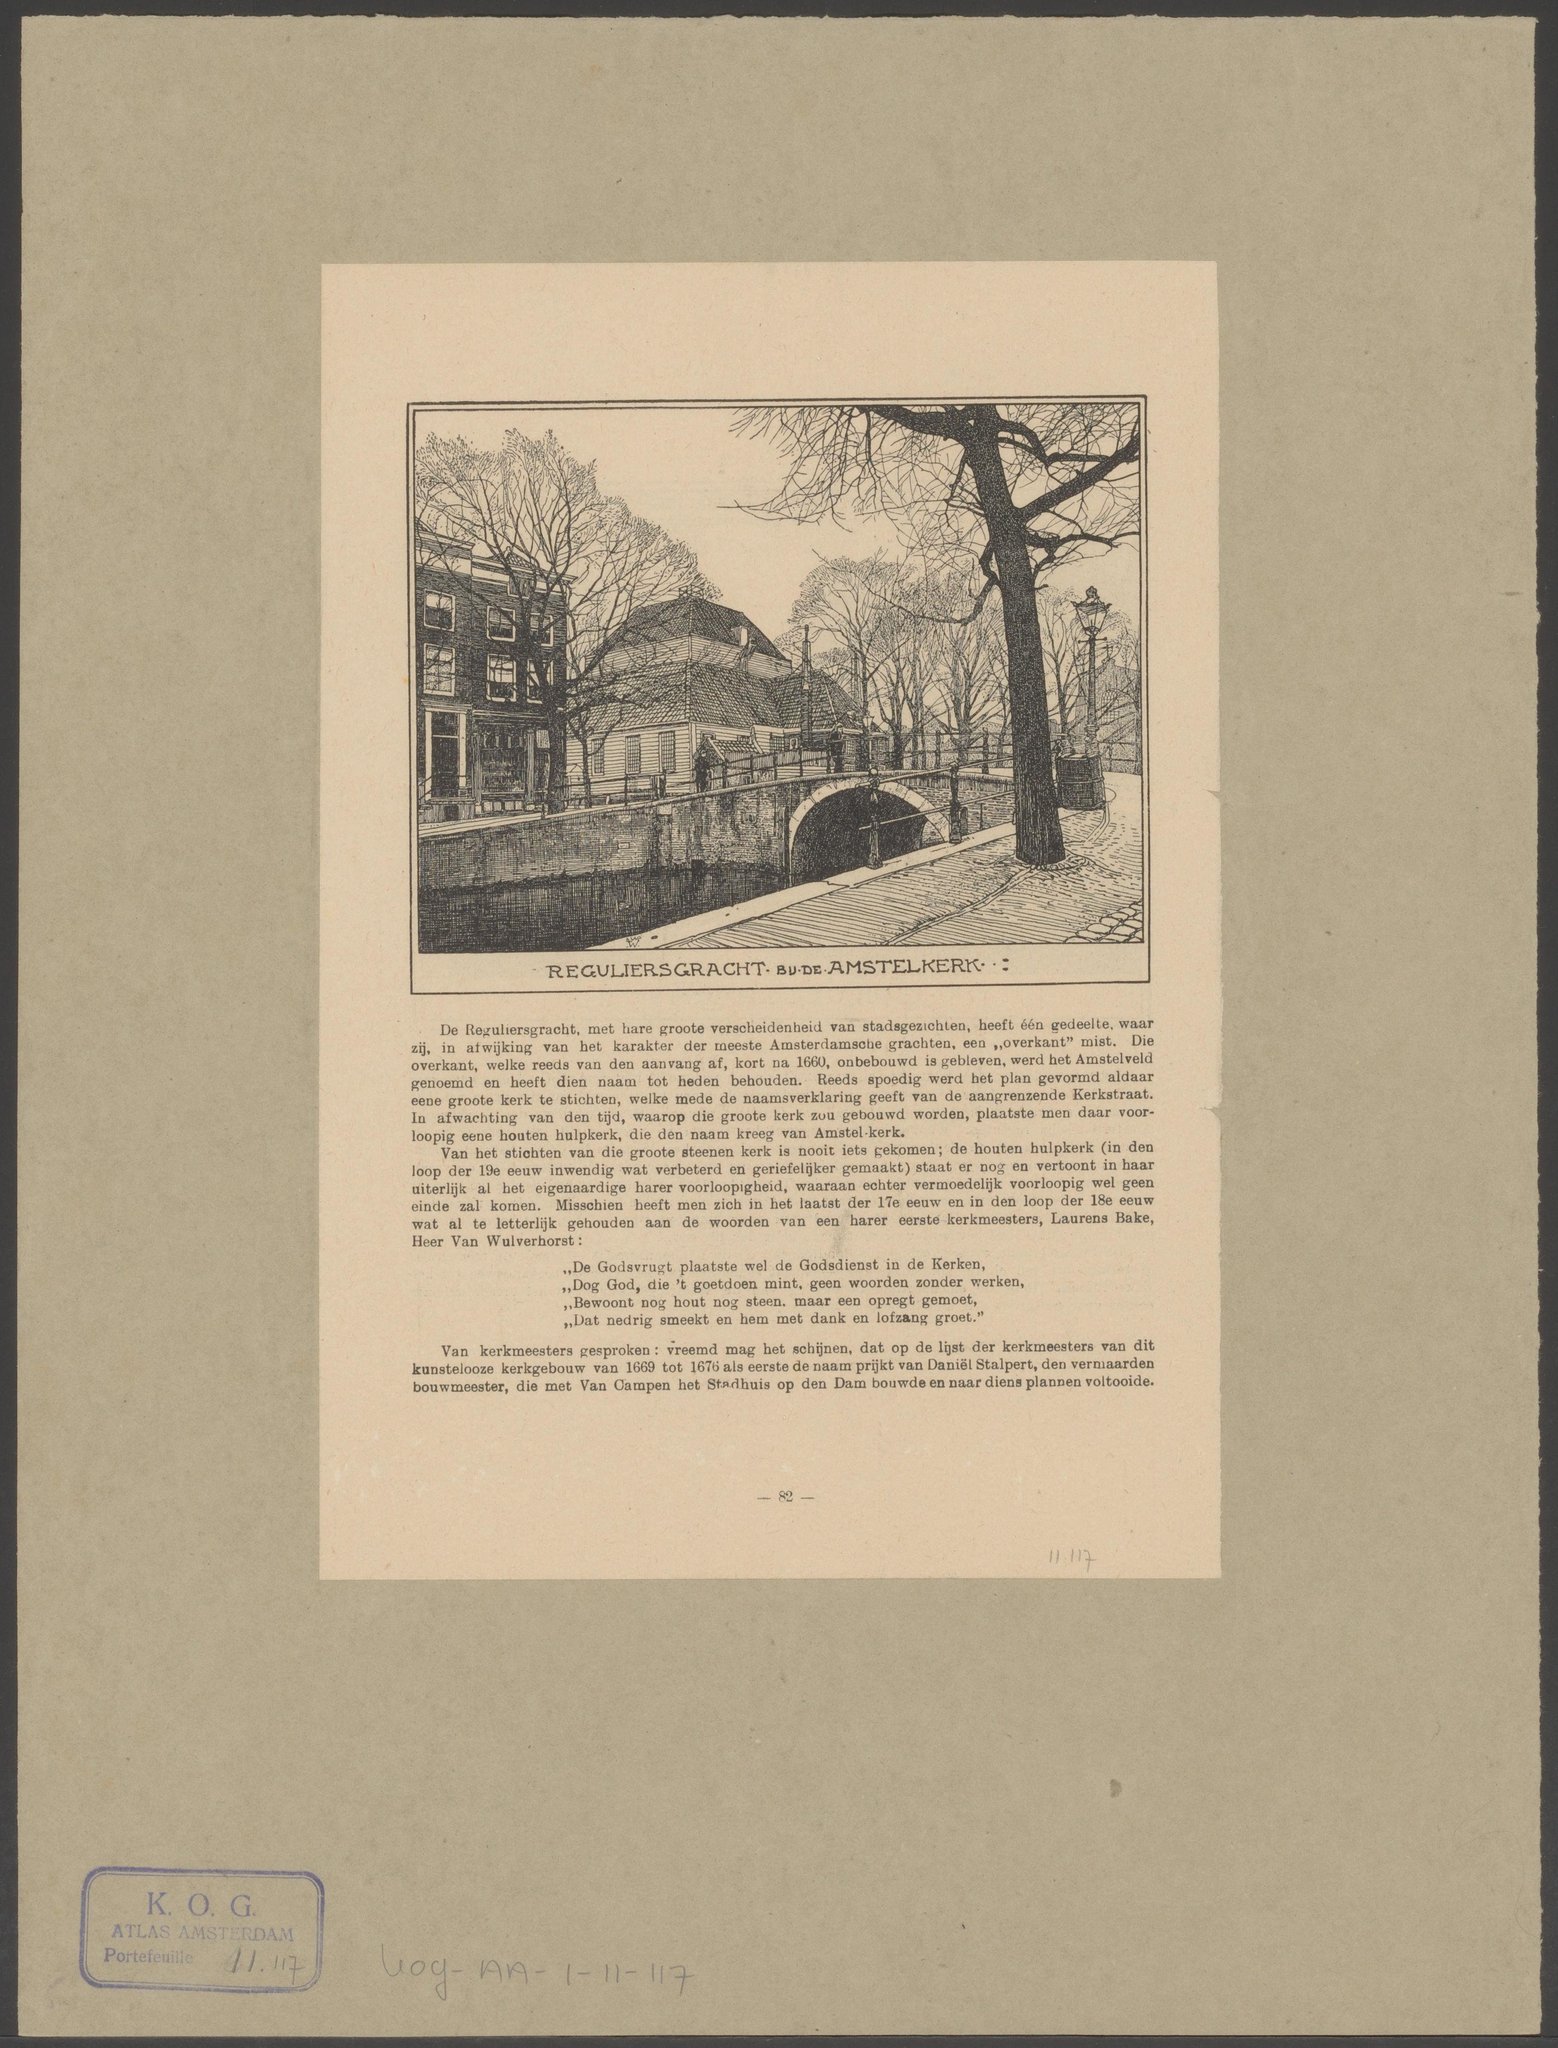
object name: photomechanical print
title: Oud-Amsterdam 100 Stadsgezichten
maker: willem wenckebach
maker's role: designer, draughtsman, painter, print maker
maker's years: 1860-1937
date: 1870-1923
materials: paper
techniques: letterpress printing, line block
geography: amsterdam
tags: city-view in general; 'veduta', canal, church (exterior), bridge in city across river, canal, etc.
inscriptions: collector's mark: ‘11.117’ Lugt 1641b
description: Onderwerpsrubriek binnen de Atlas Amsterdam: Raadhuisstraat, Raamgracht, Raamplein, Rapenburgerstraat, Reguliersgracht, Reguliersbreestraat.